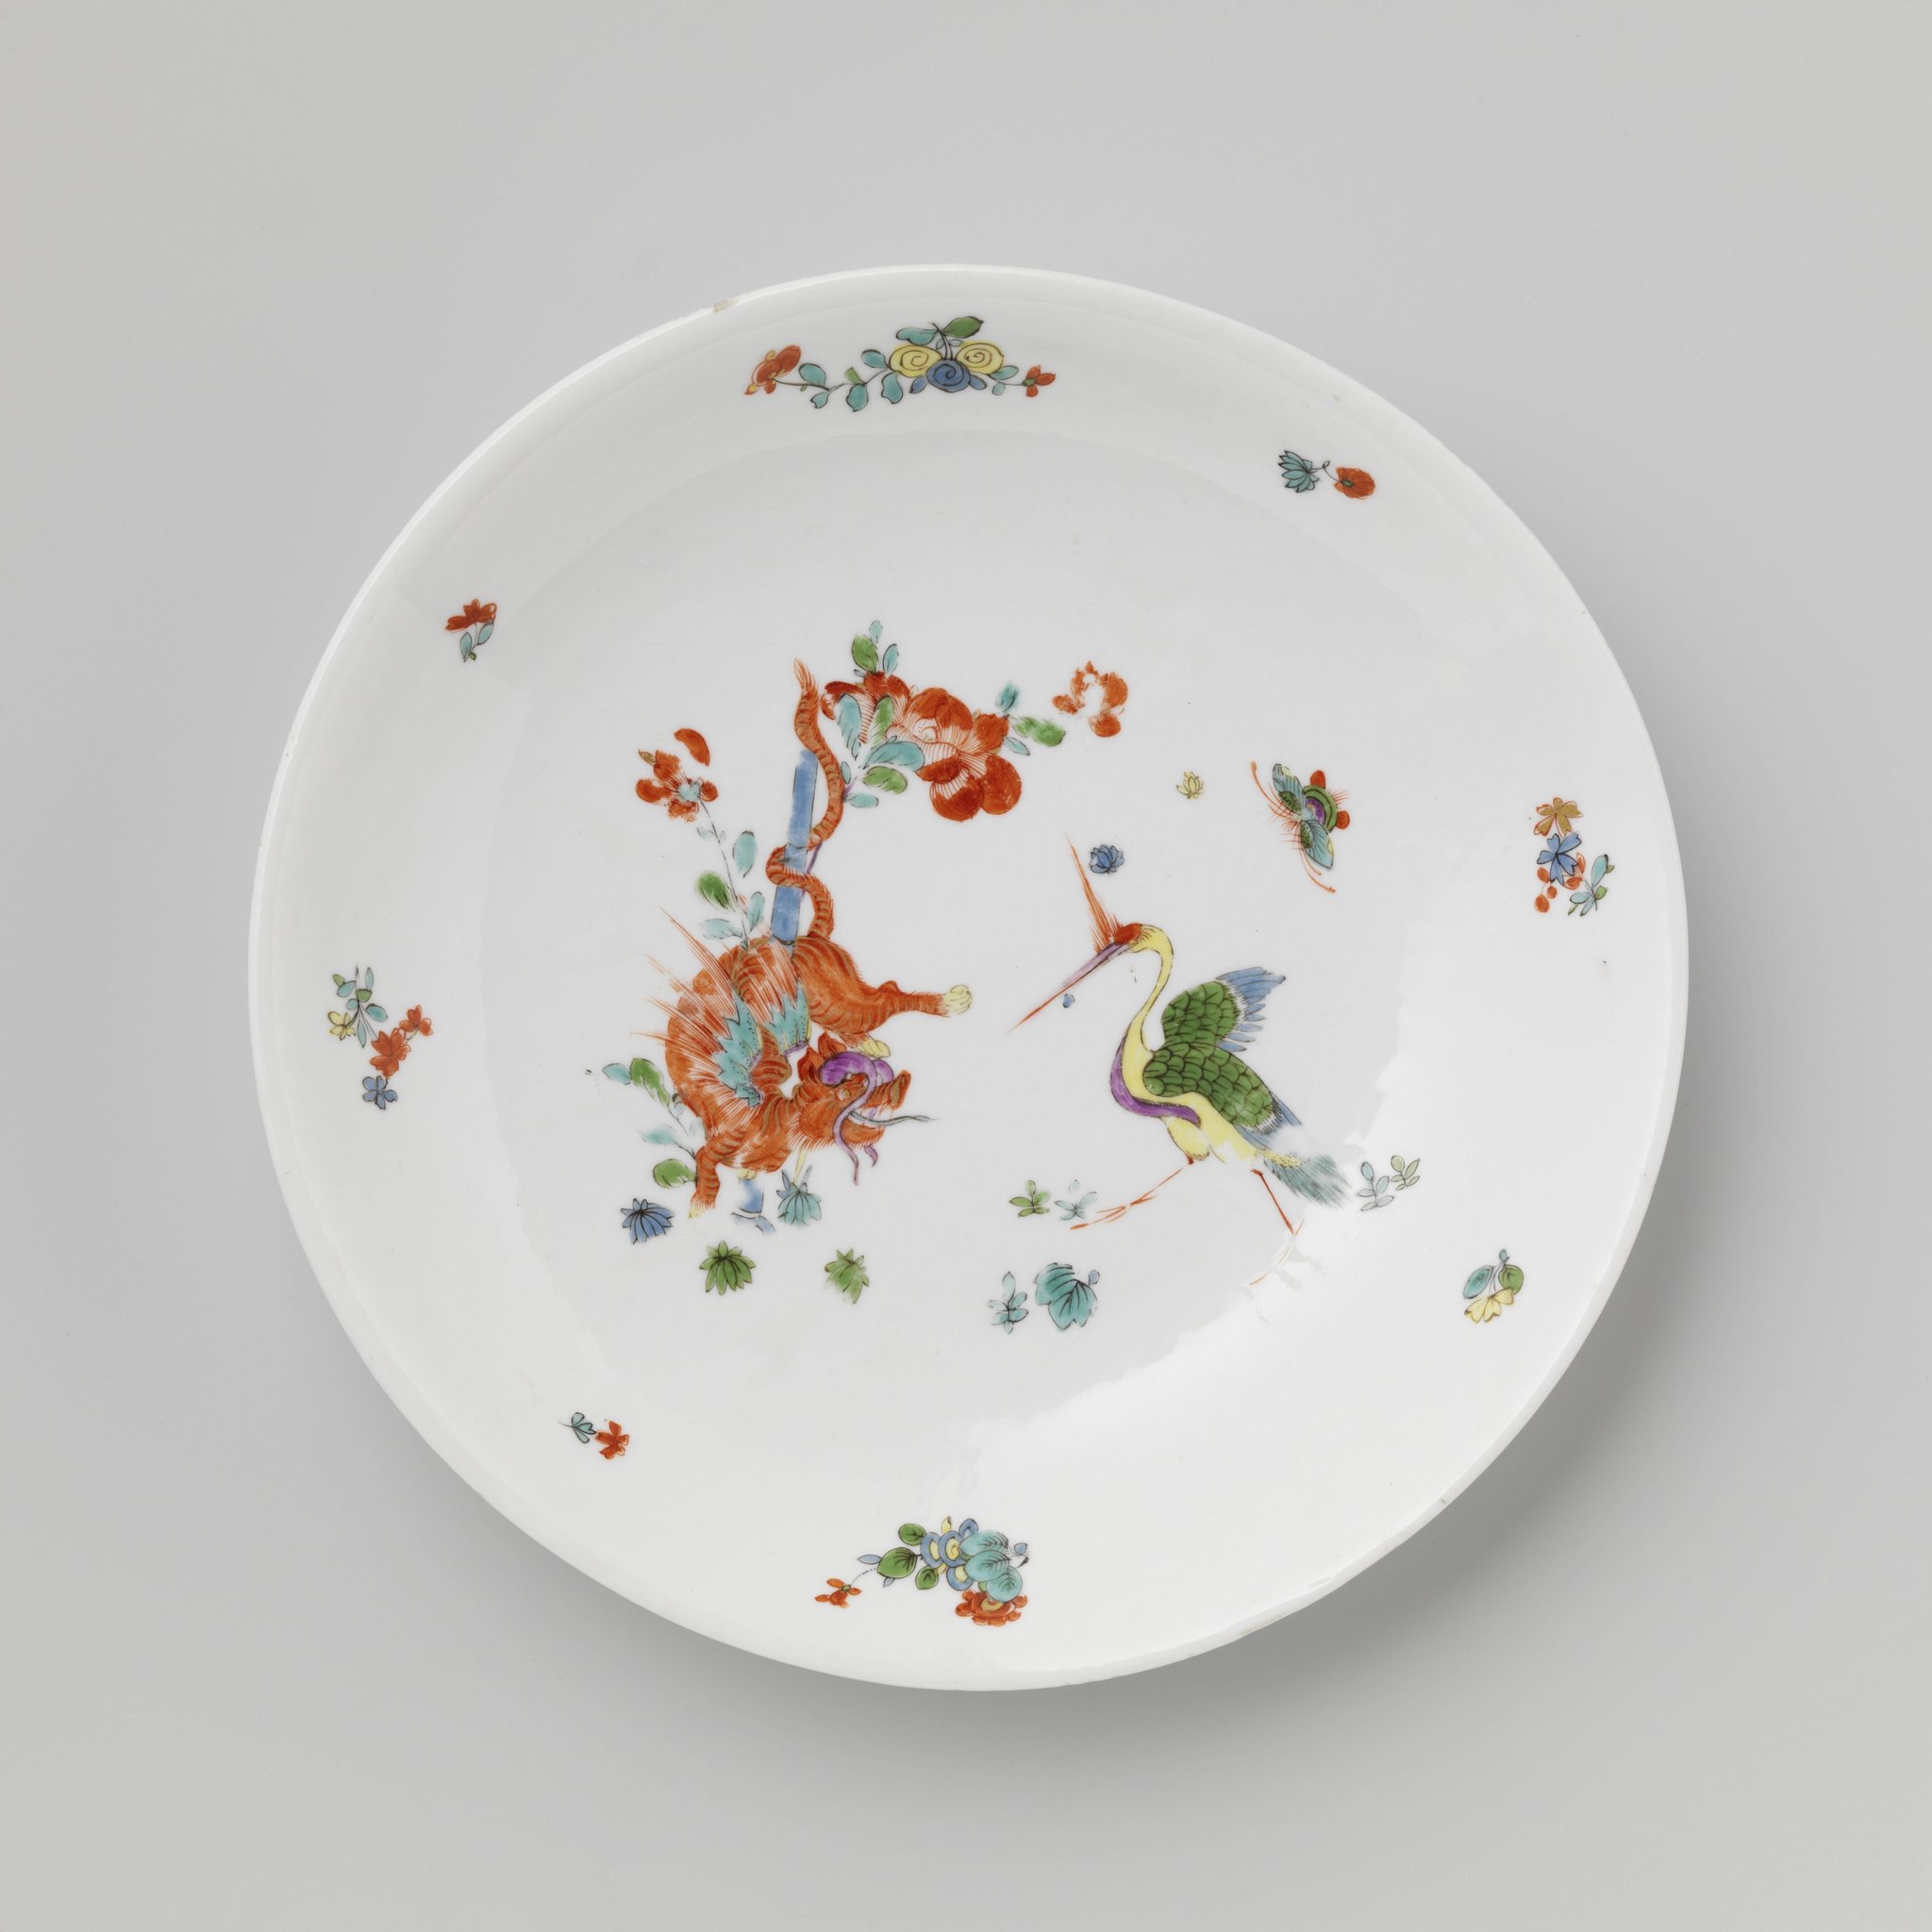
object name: dish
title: Schaal, veelkleurig beschilderd met een Kakiemon-decor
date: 1730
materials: porcelain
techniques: painted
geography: meissen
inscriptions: mold mark, factory mark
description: Dish. Meissen, ca. 1725 - 1735.